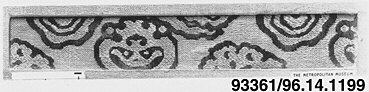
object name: piece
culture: japanese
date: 1701-1900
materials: silk